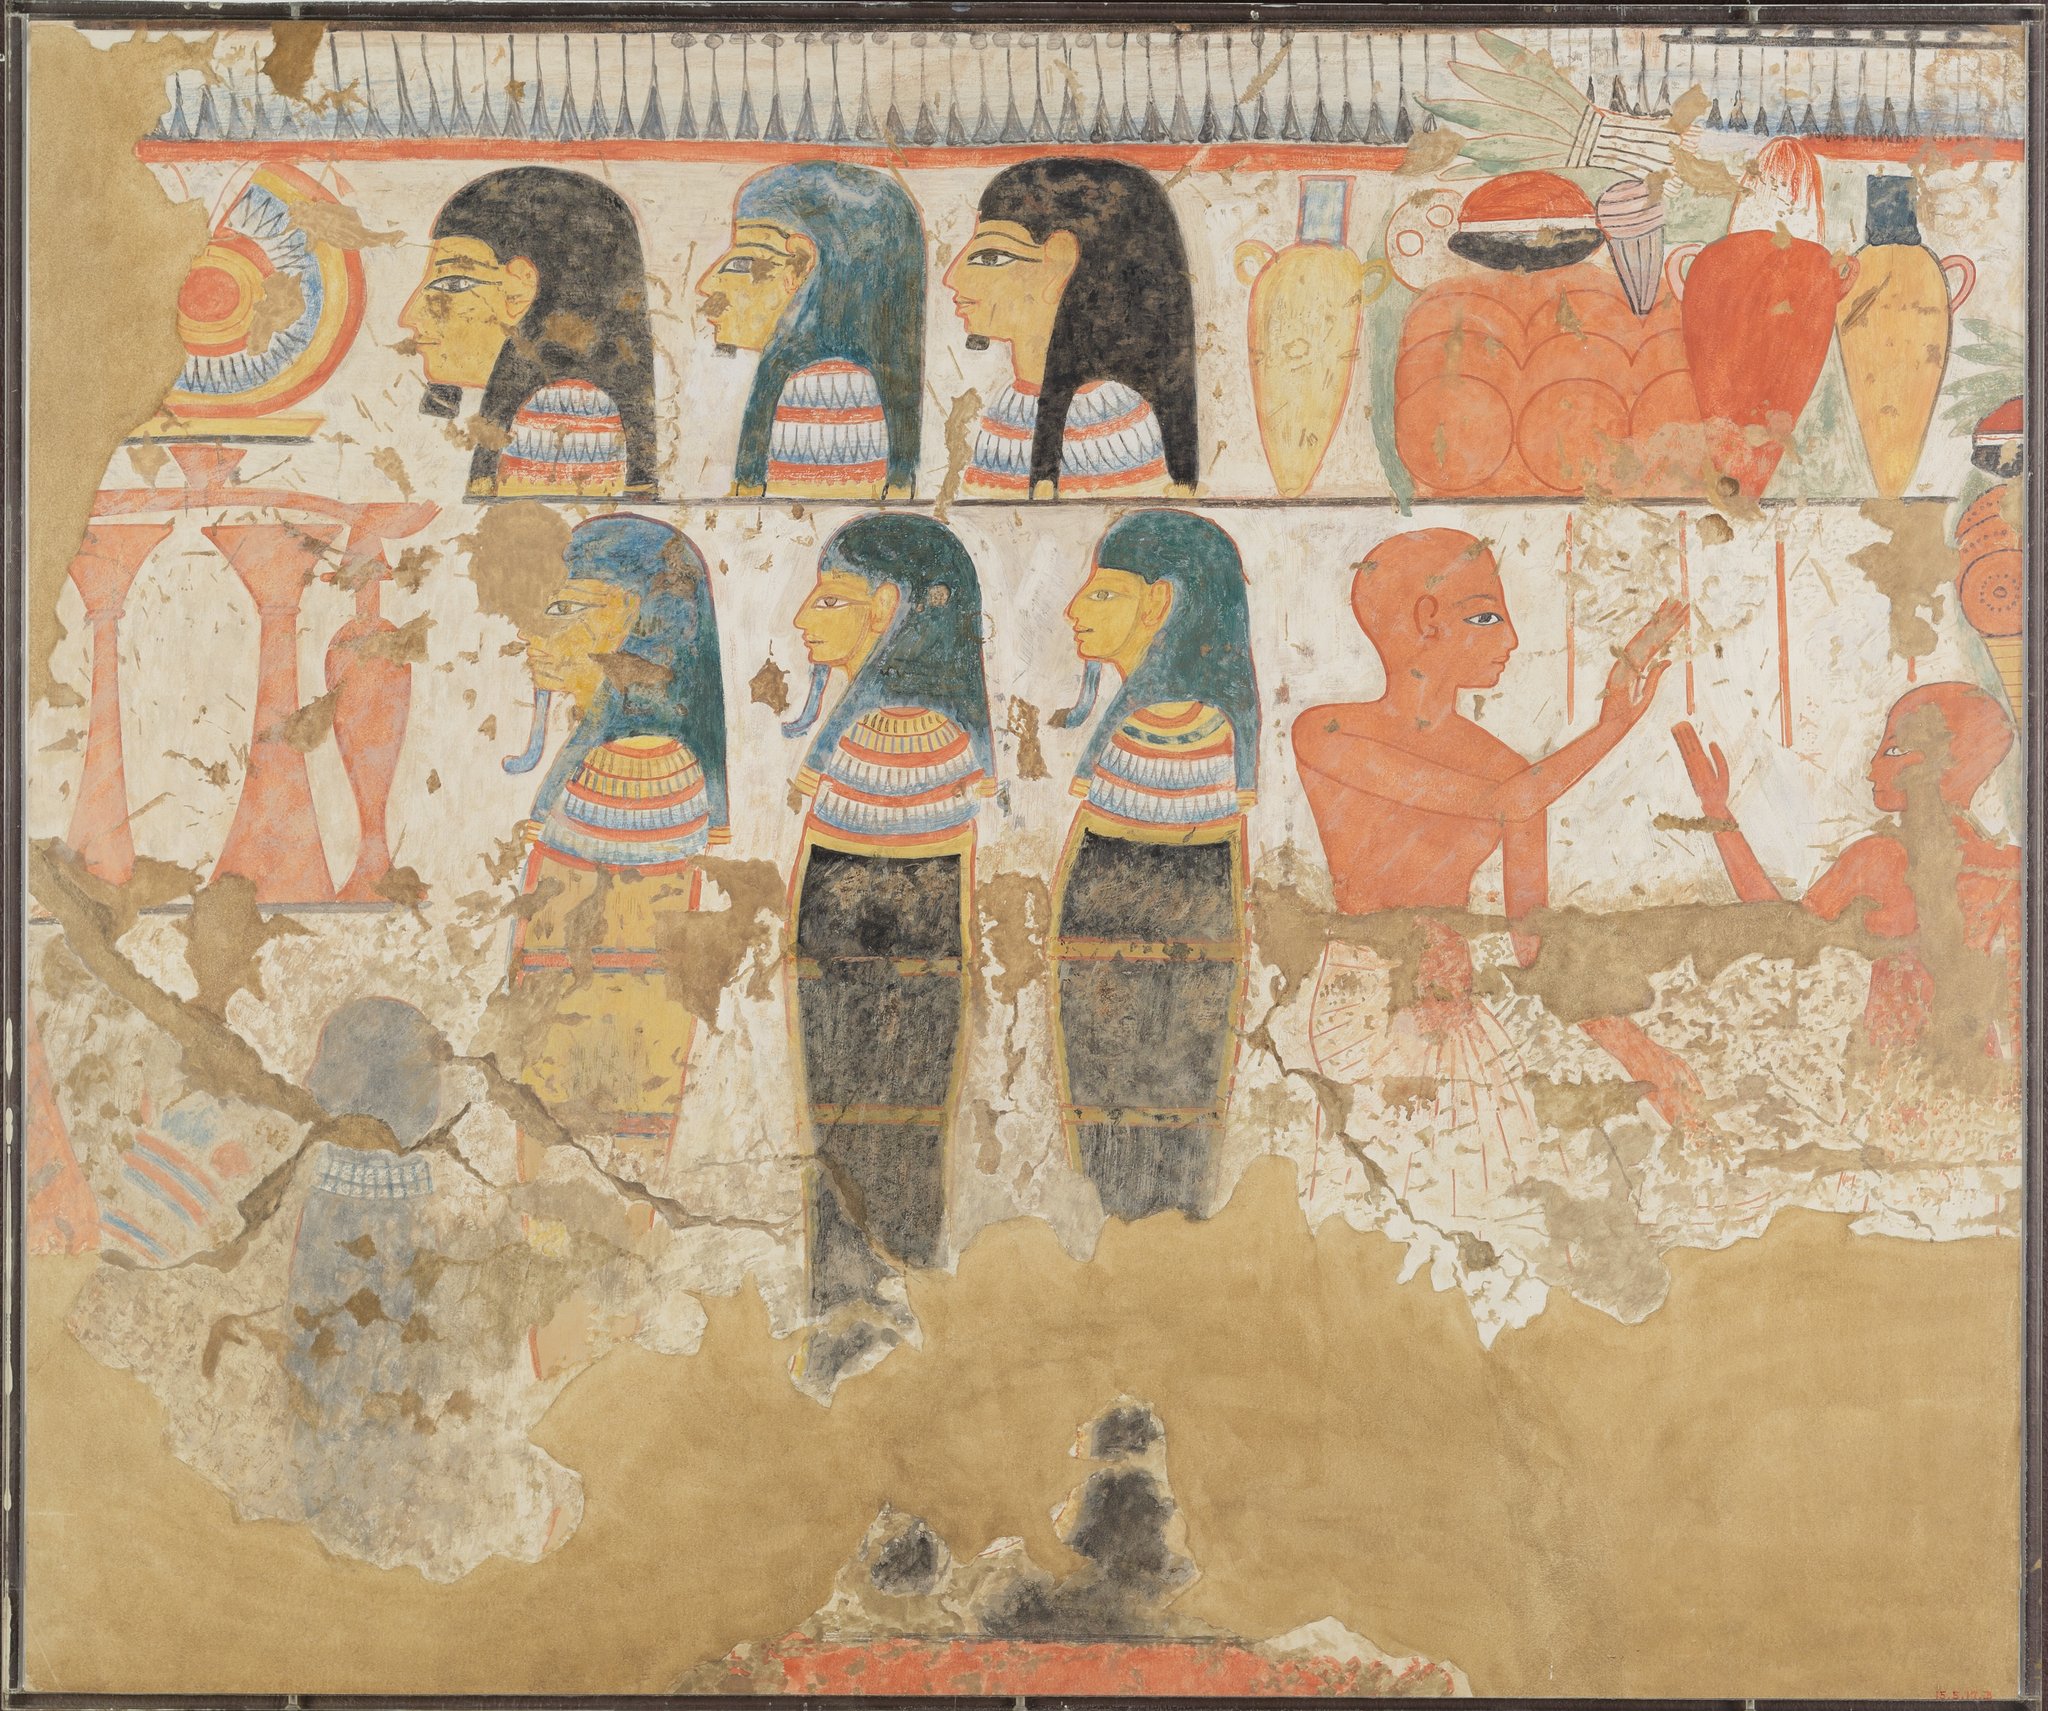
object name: facsimile, userhat tt 51, funerary equipment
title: Funerary Equipment, Tomb of Userhat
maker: norman de garis davies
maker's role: artist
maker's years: 1865-1941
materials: paper, paint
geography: egypt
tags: men,women